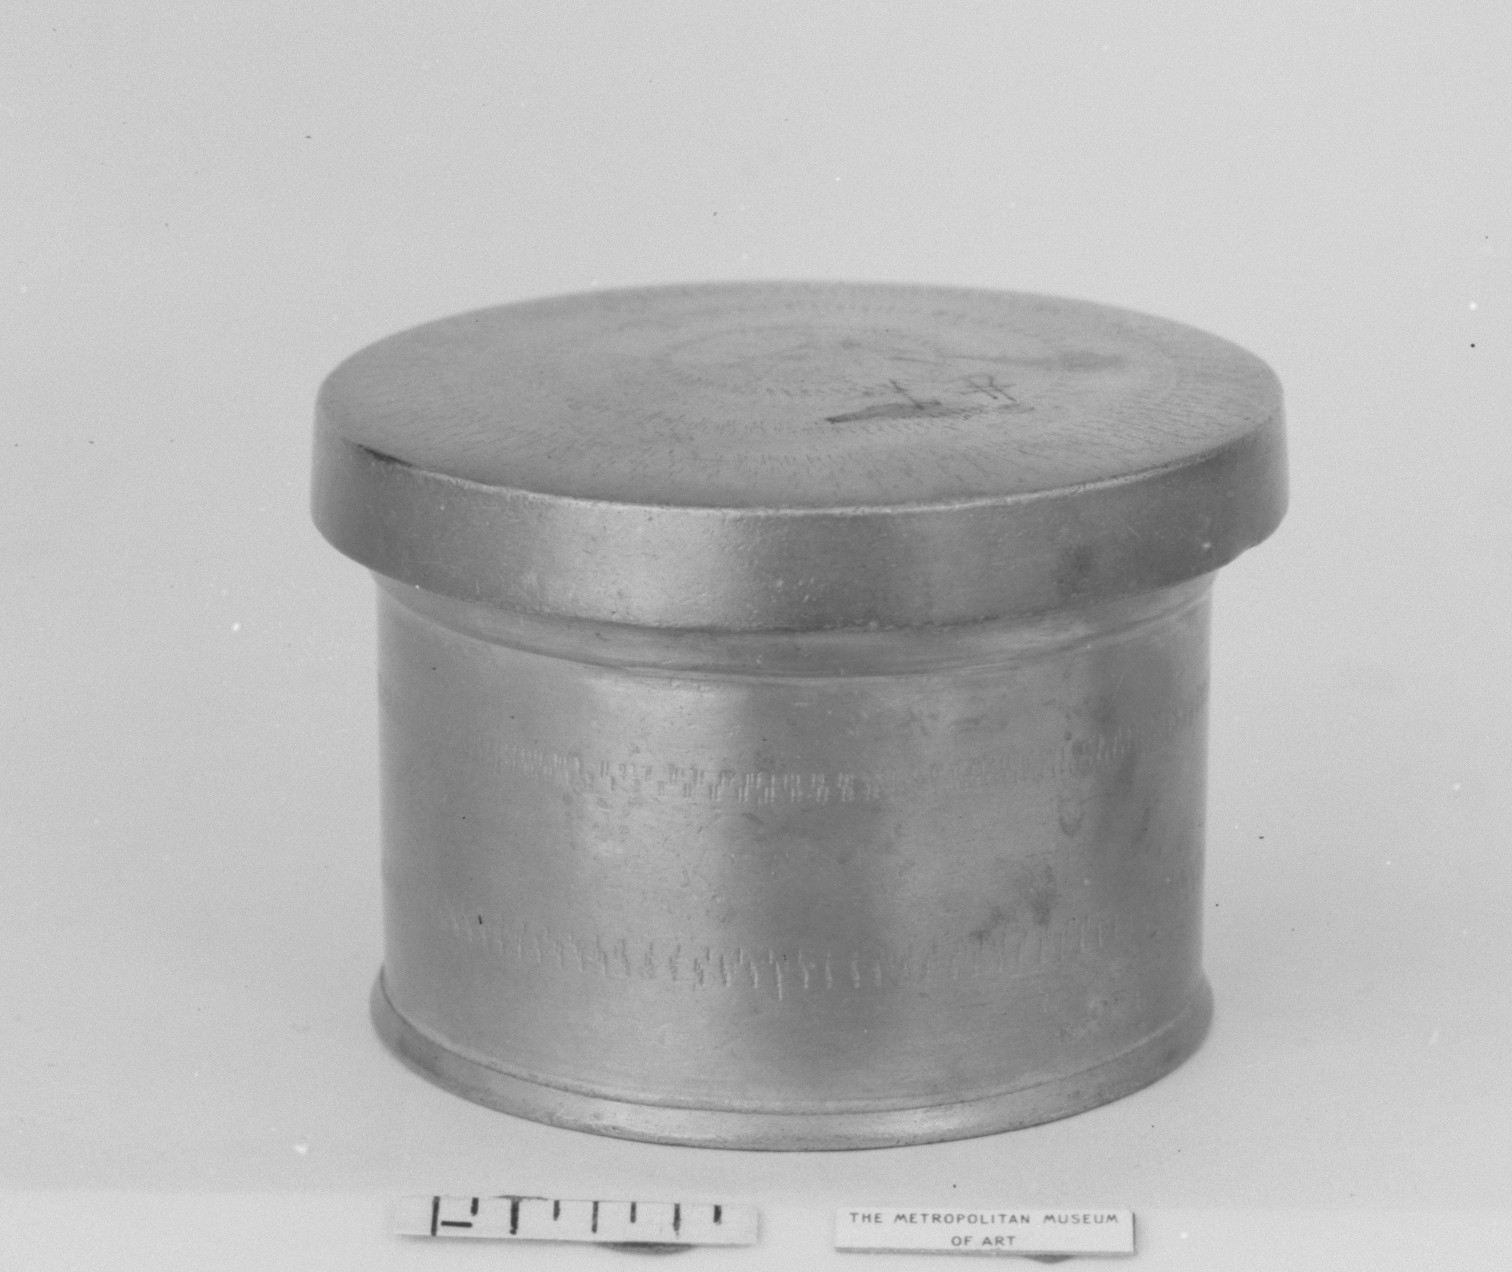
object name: box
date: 1701-1800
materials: pewter